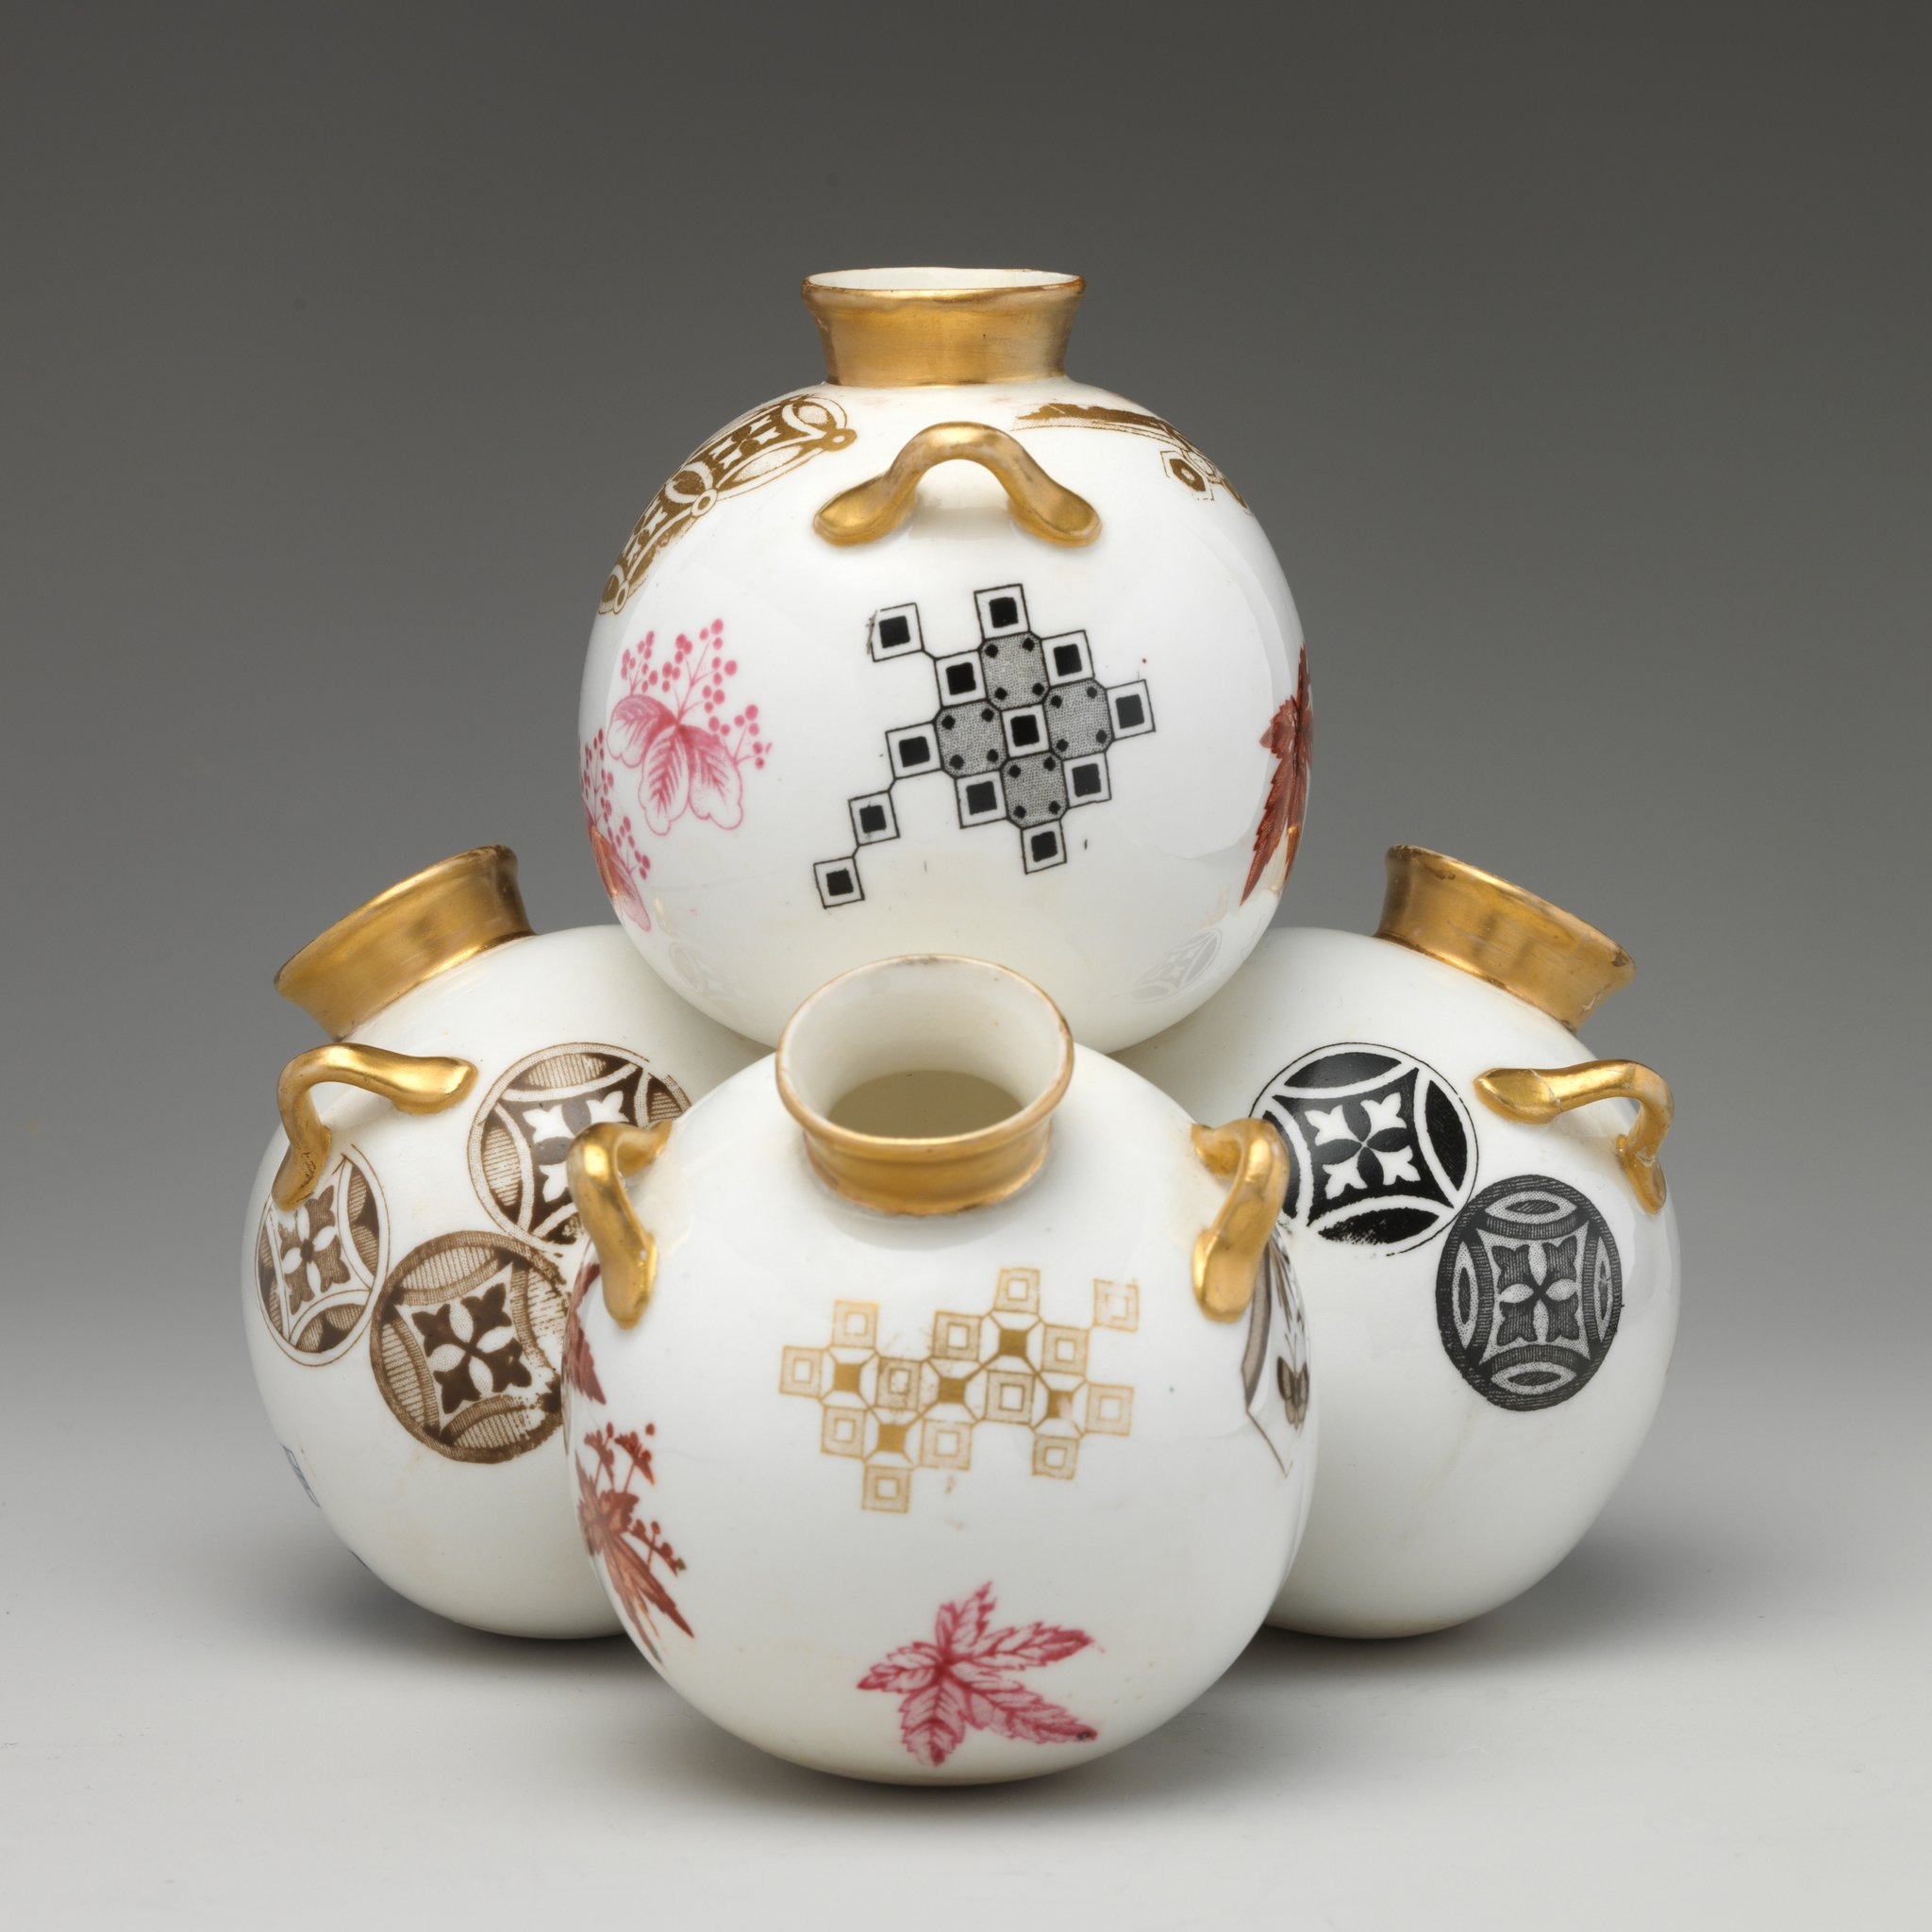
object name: vase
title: Quadruple orb vase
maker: worcester factory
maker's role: maker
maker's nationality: british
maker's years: 1751-2008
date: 1876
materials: porcelain